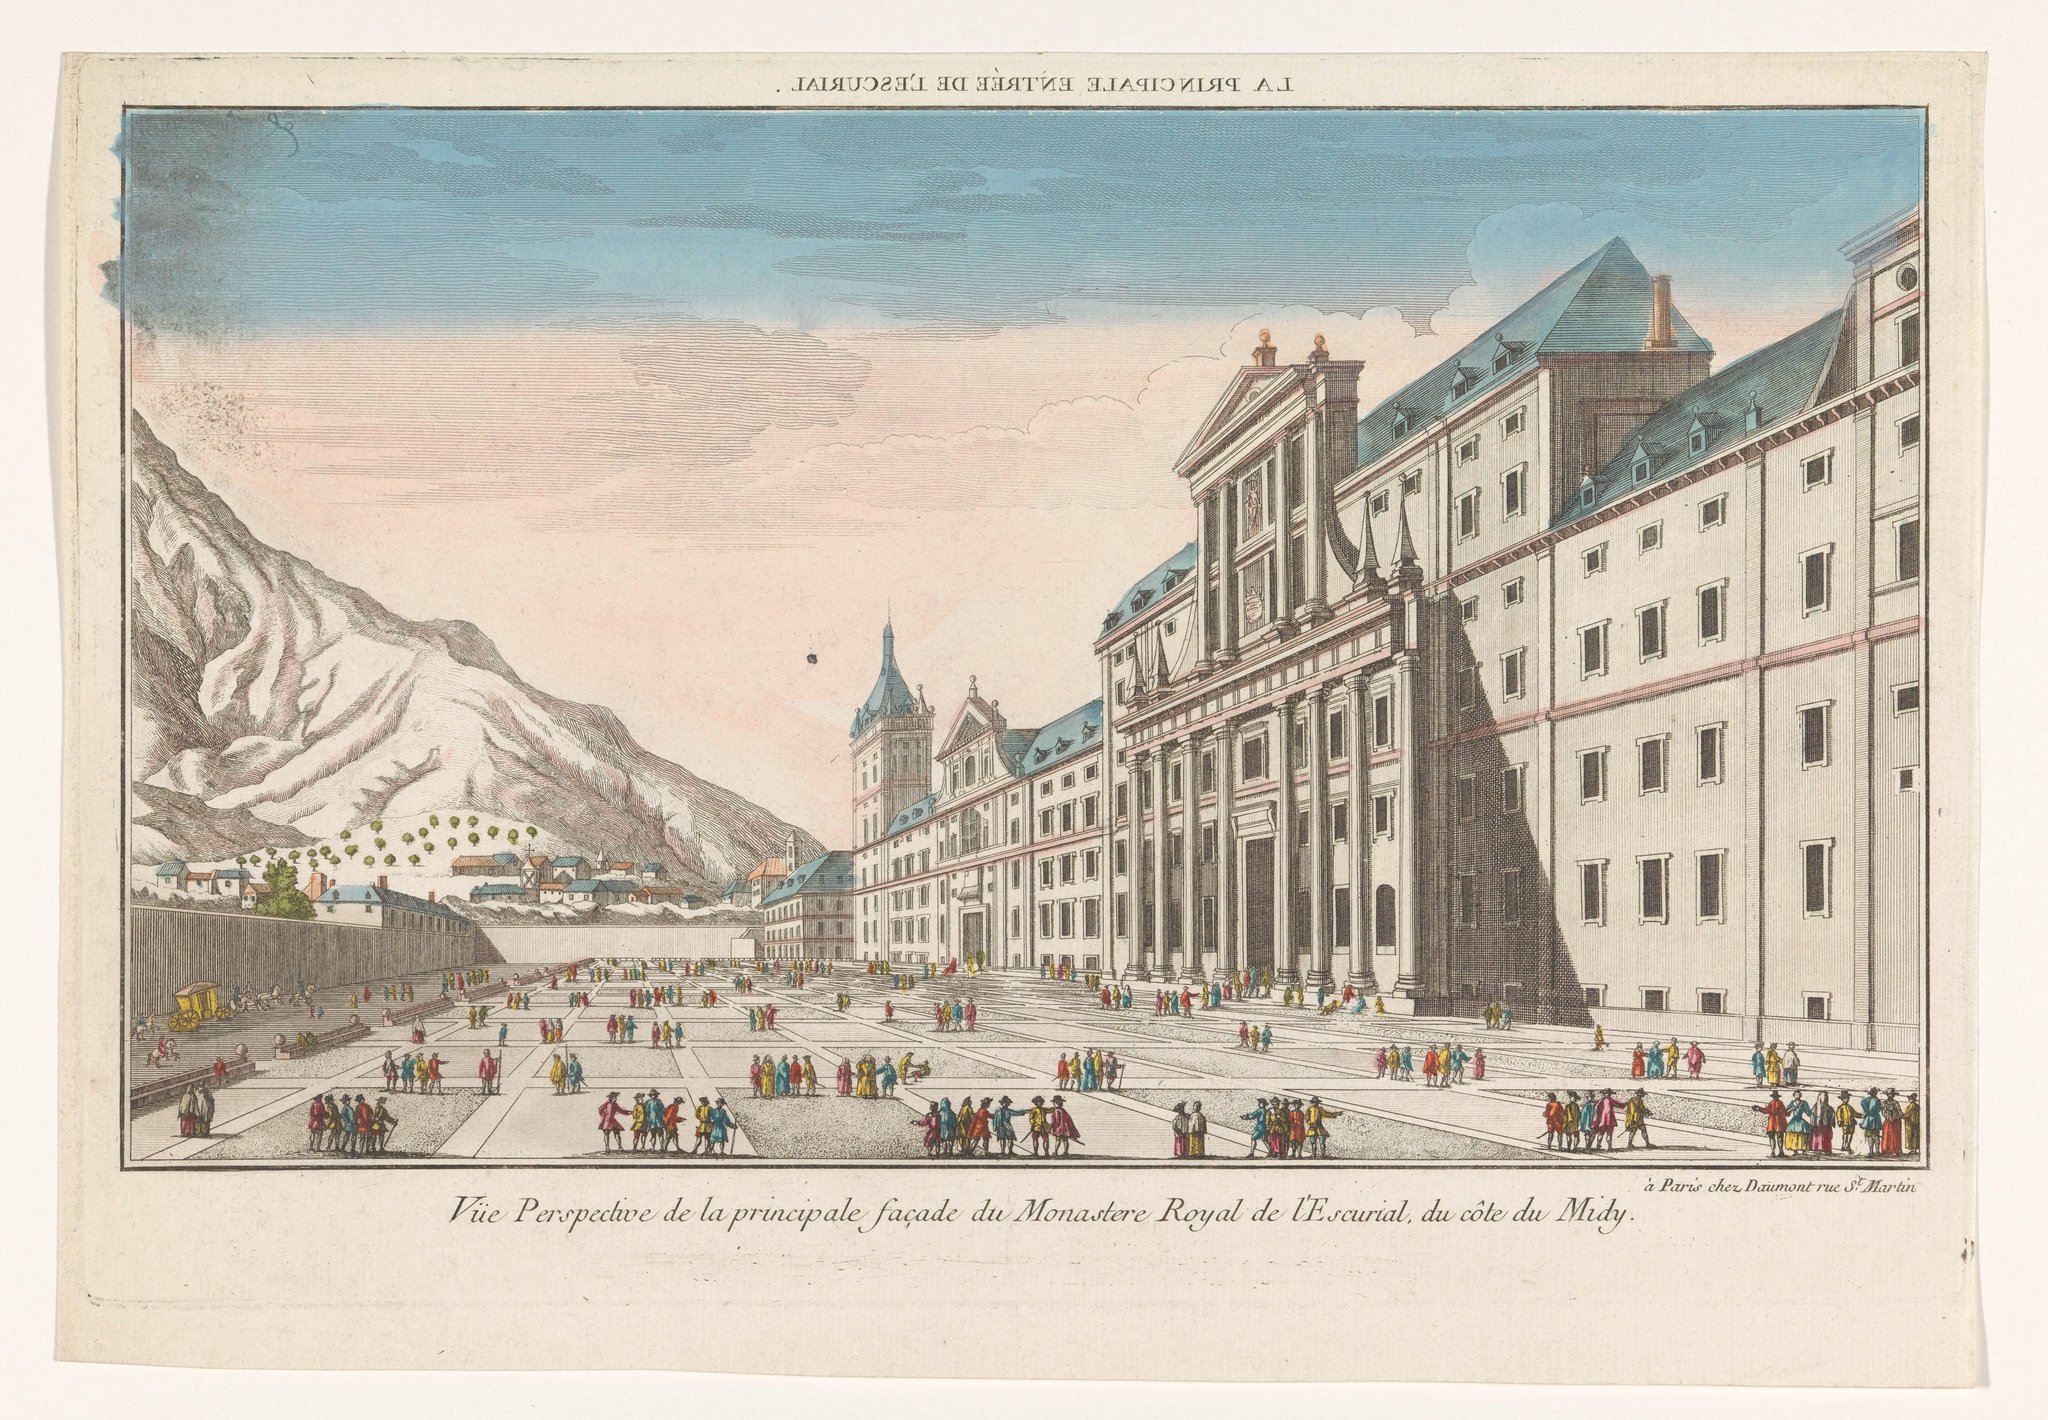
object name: print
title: Gezicht op het abdijcomplex El Escorial in de omgeving van de stad Madrid, gezien vanaf de zuidzijde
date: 1745-1775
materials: paper, watercolor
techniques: brush, etching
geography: paris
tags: abbey, monastery, convent ~ roman catholic church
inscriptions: collector's mark: Lugt 2233, watermark